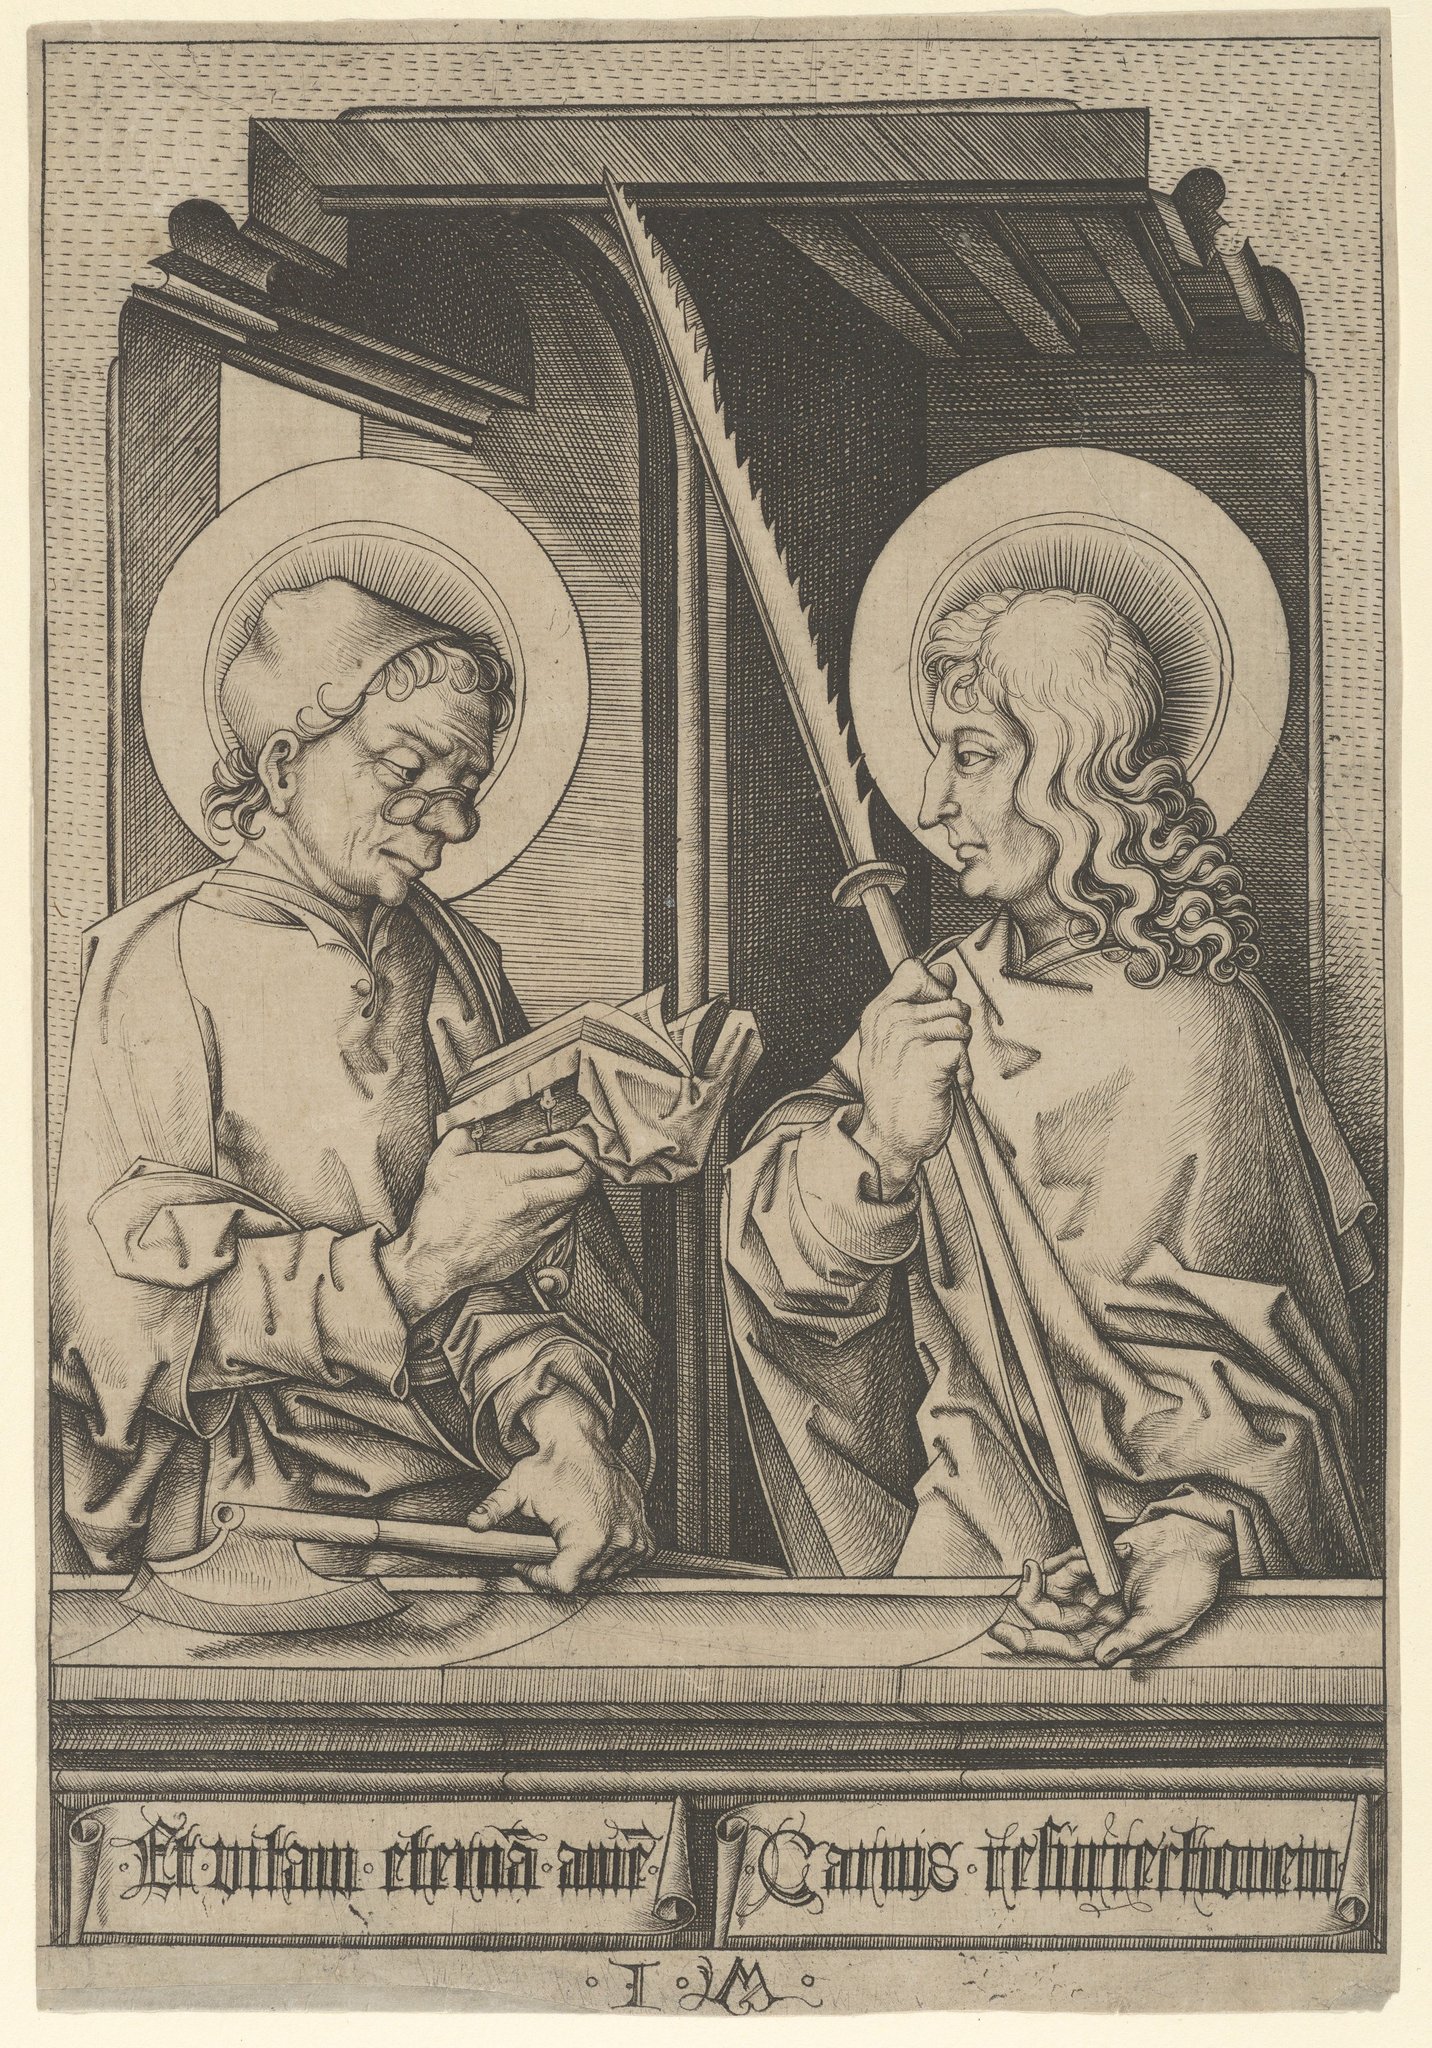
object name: print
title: Saints Matthias and Judas Thaddaeus, from "The Apostles"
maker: israhel van meckenem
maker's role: artist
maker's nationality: german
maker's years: 1435-1503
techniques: engraving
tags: books,weapons,reading,apostles,saints